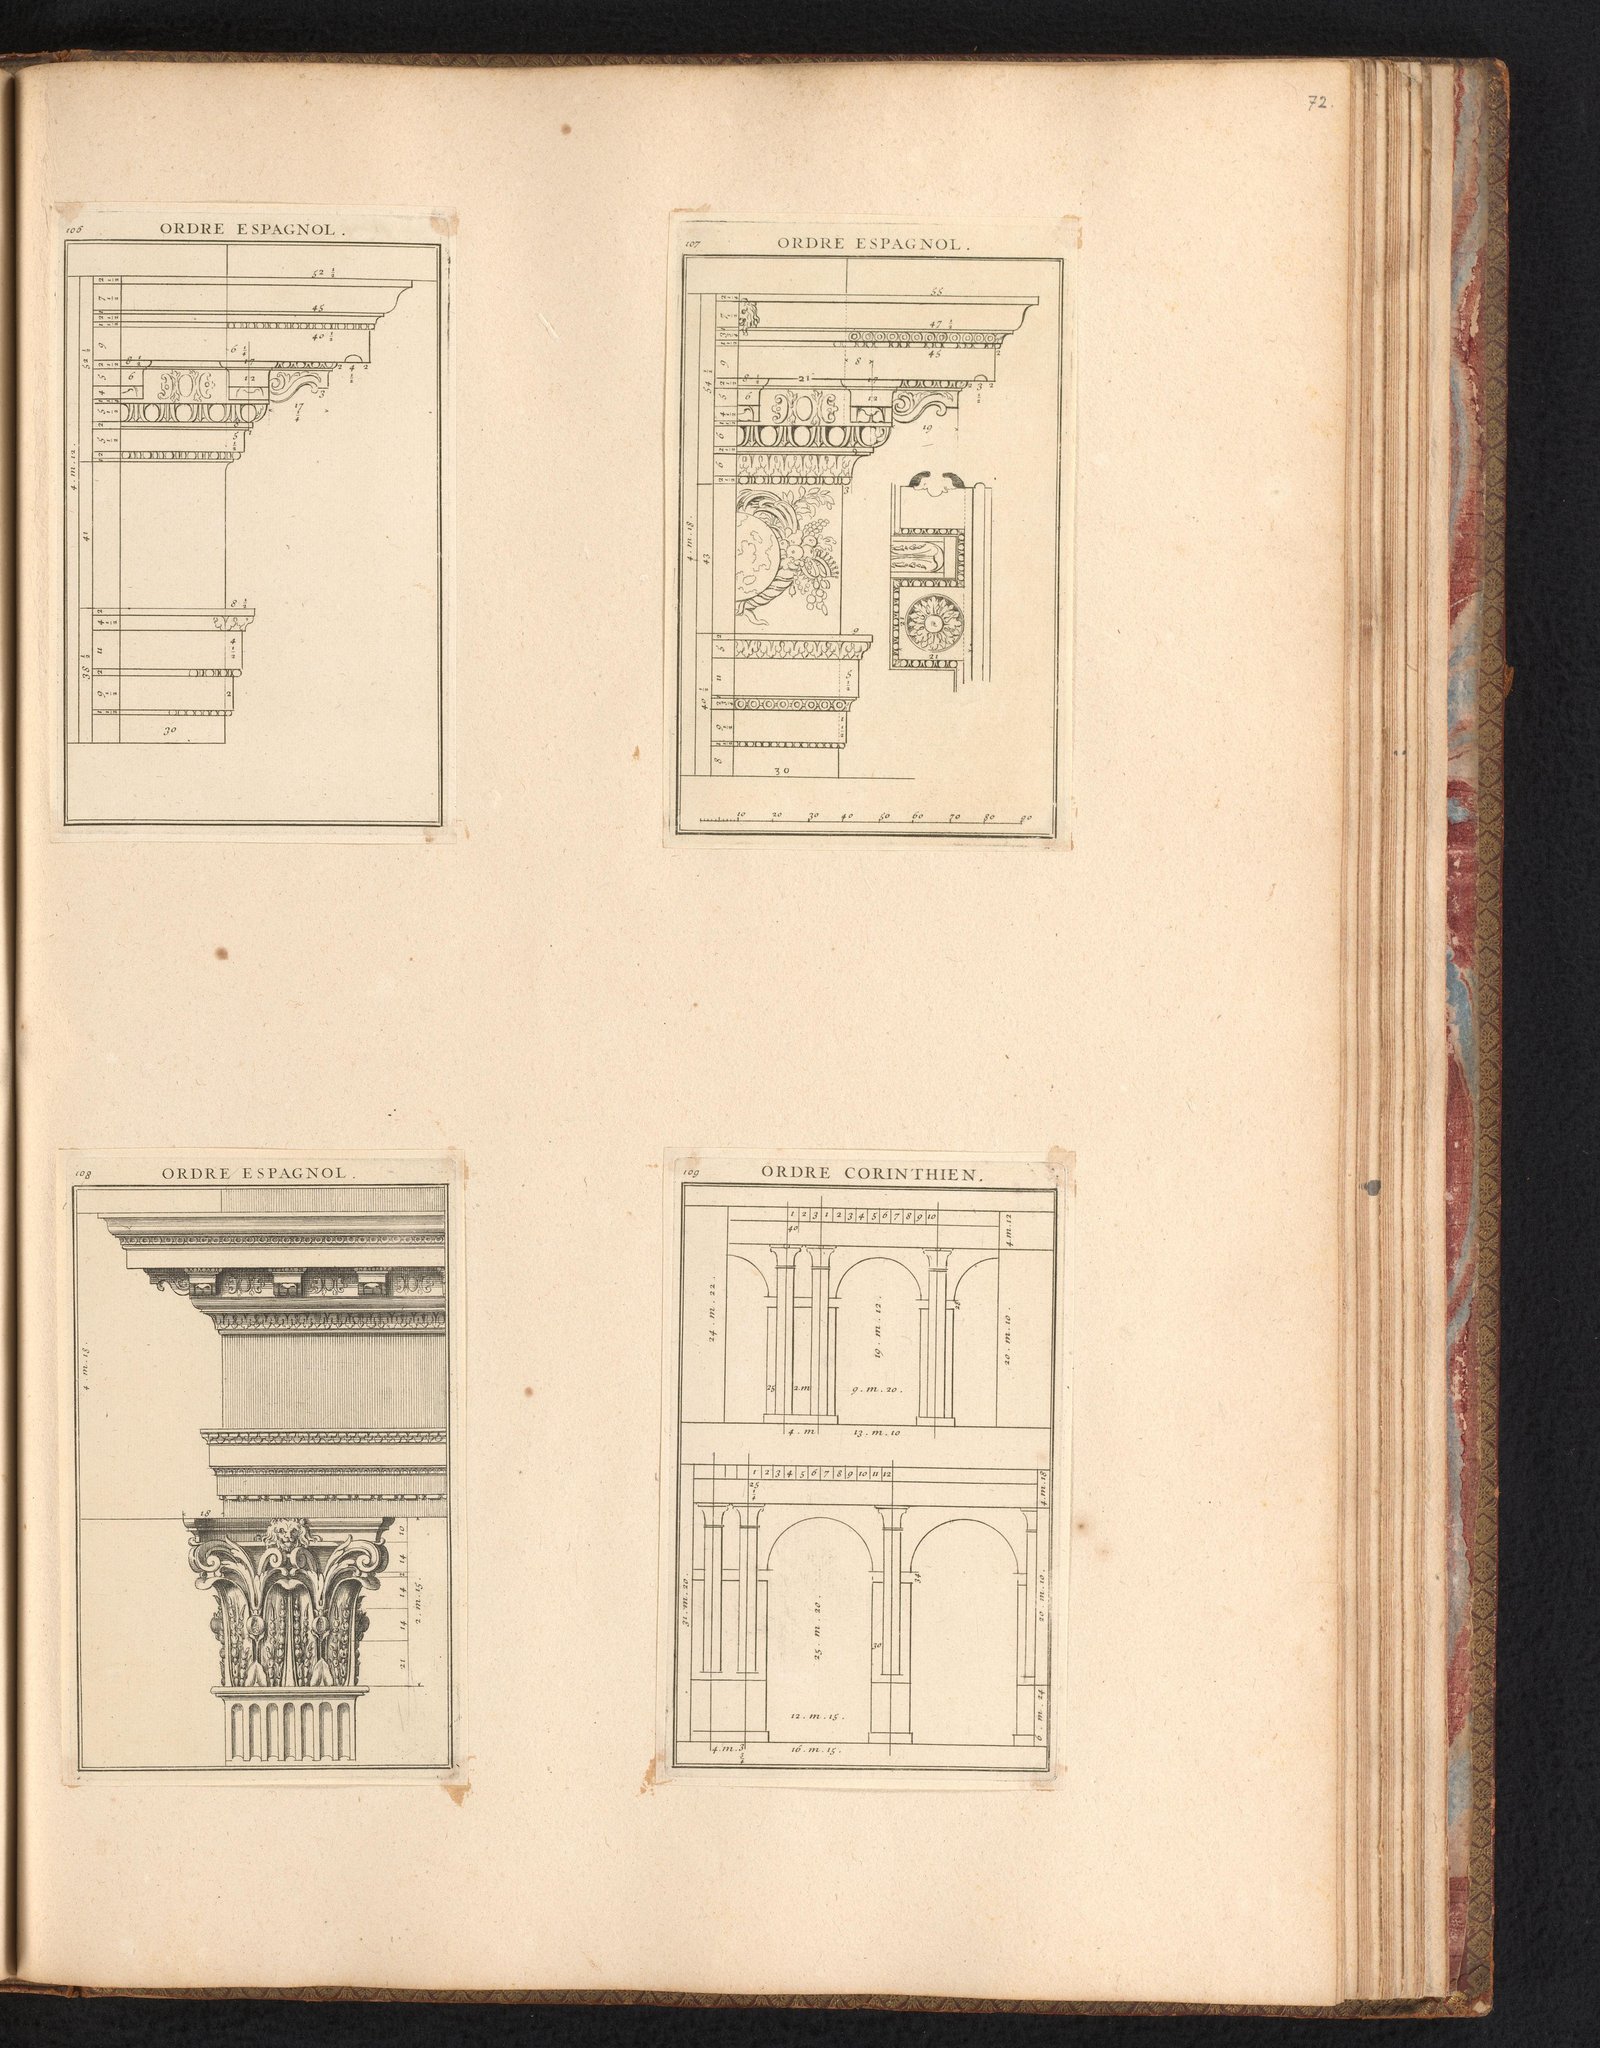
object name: print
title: Ordre Espagnol/ Ordre Corinthien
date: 1714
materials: paper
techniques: etching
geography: paris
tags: orders, order-books ~ architecture, half-column, pilaster ~ architecture, corinthian order ~ architecture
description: Prenten uit: Leclerc, Sébastien (I). Traité d'architecture. Parijs: Pierre François Giffart, 1714.